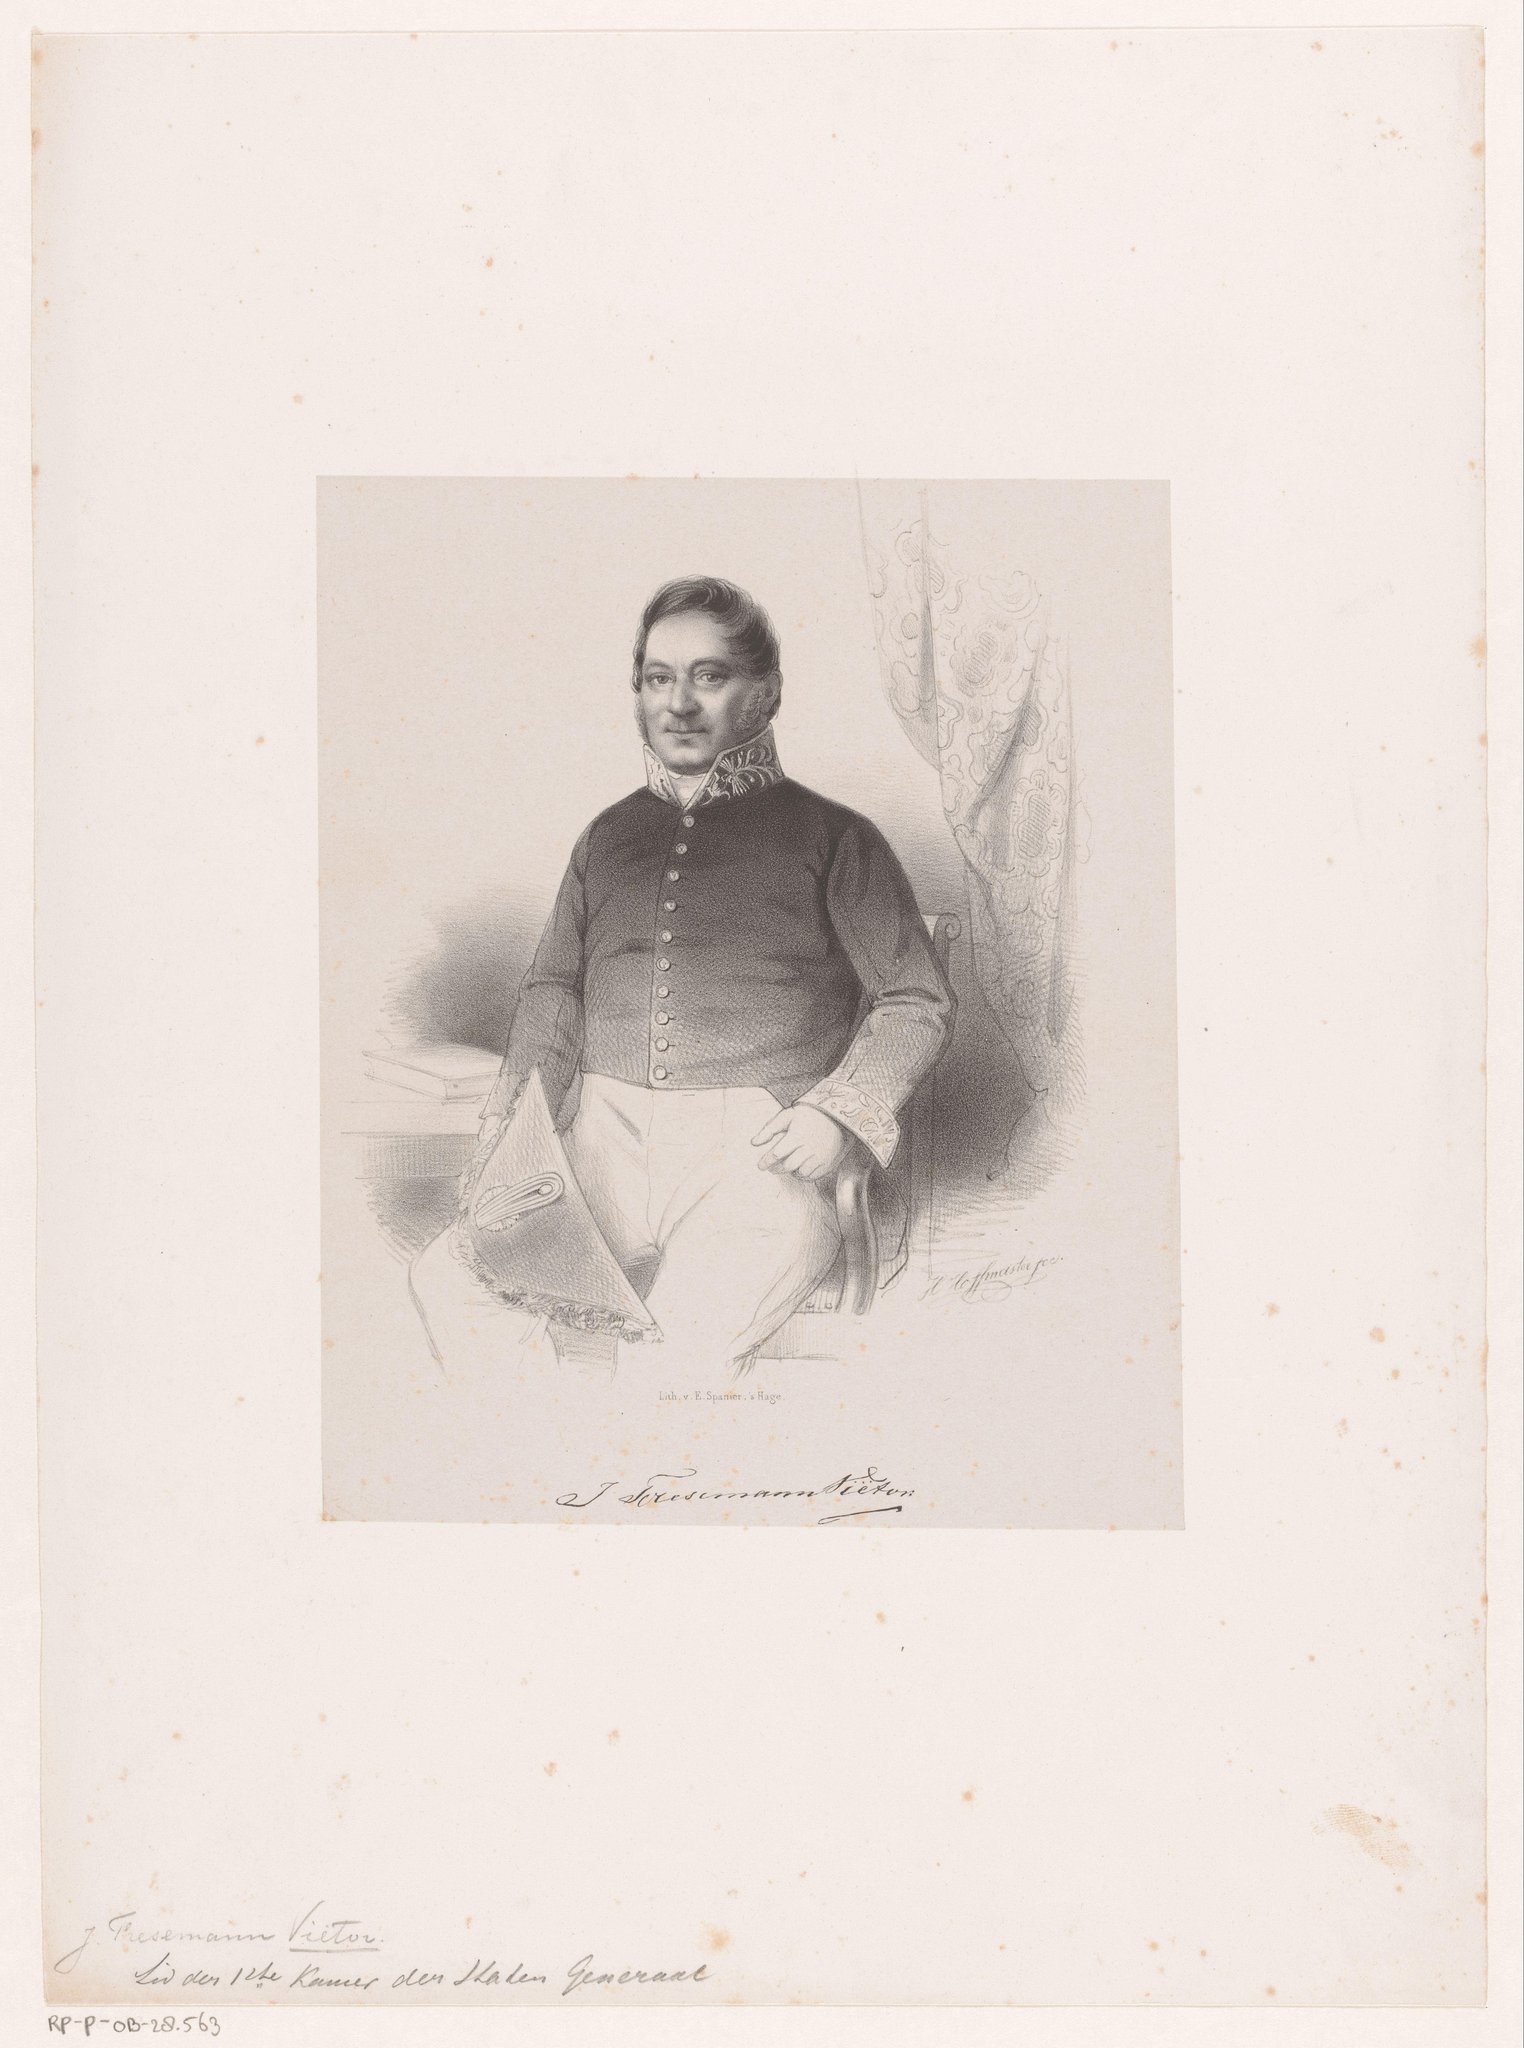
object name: print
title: Portret van Jan Fresemann Viëtor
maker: johan hendrik hoffmeister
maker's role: print maker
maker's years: 1823-1904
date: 1851-1883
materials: paper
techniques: lithograph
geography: netherlands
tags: historical persons (+ three-quarter length portrait)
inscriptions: collector's mark: Lugt 2228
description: De geportretteerde heeft zijn hoed in zijn rechterhand. Onder het portret zijn signatuur.